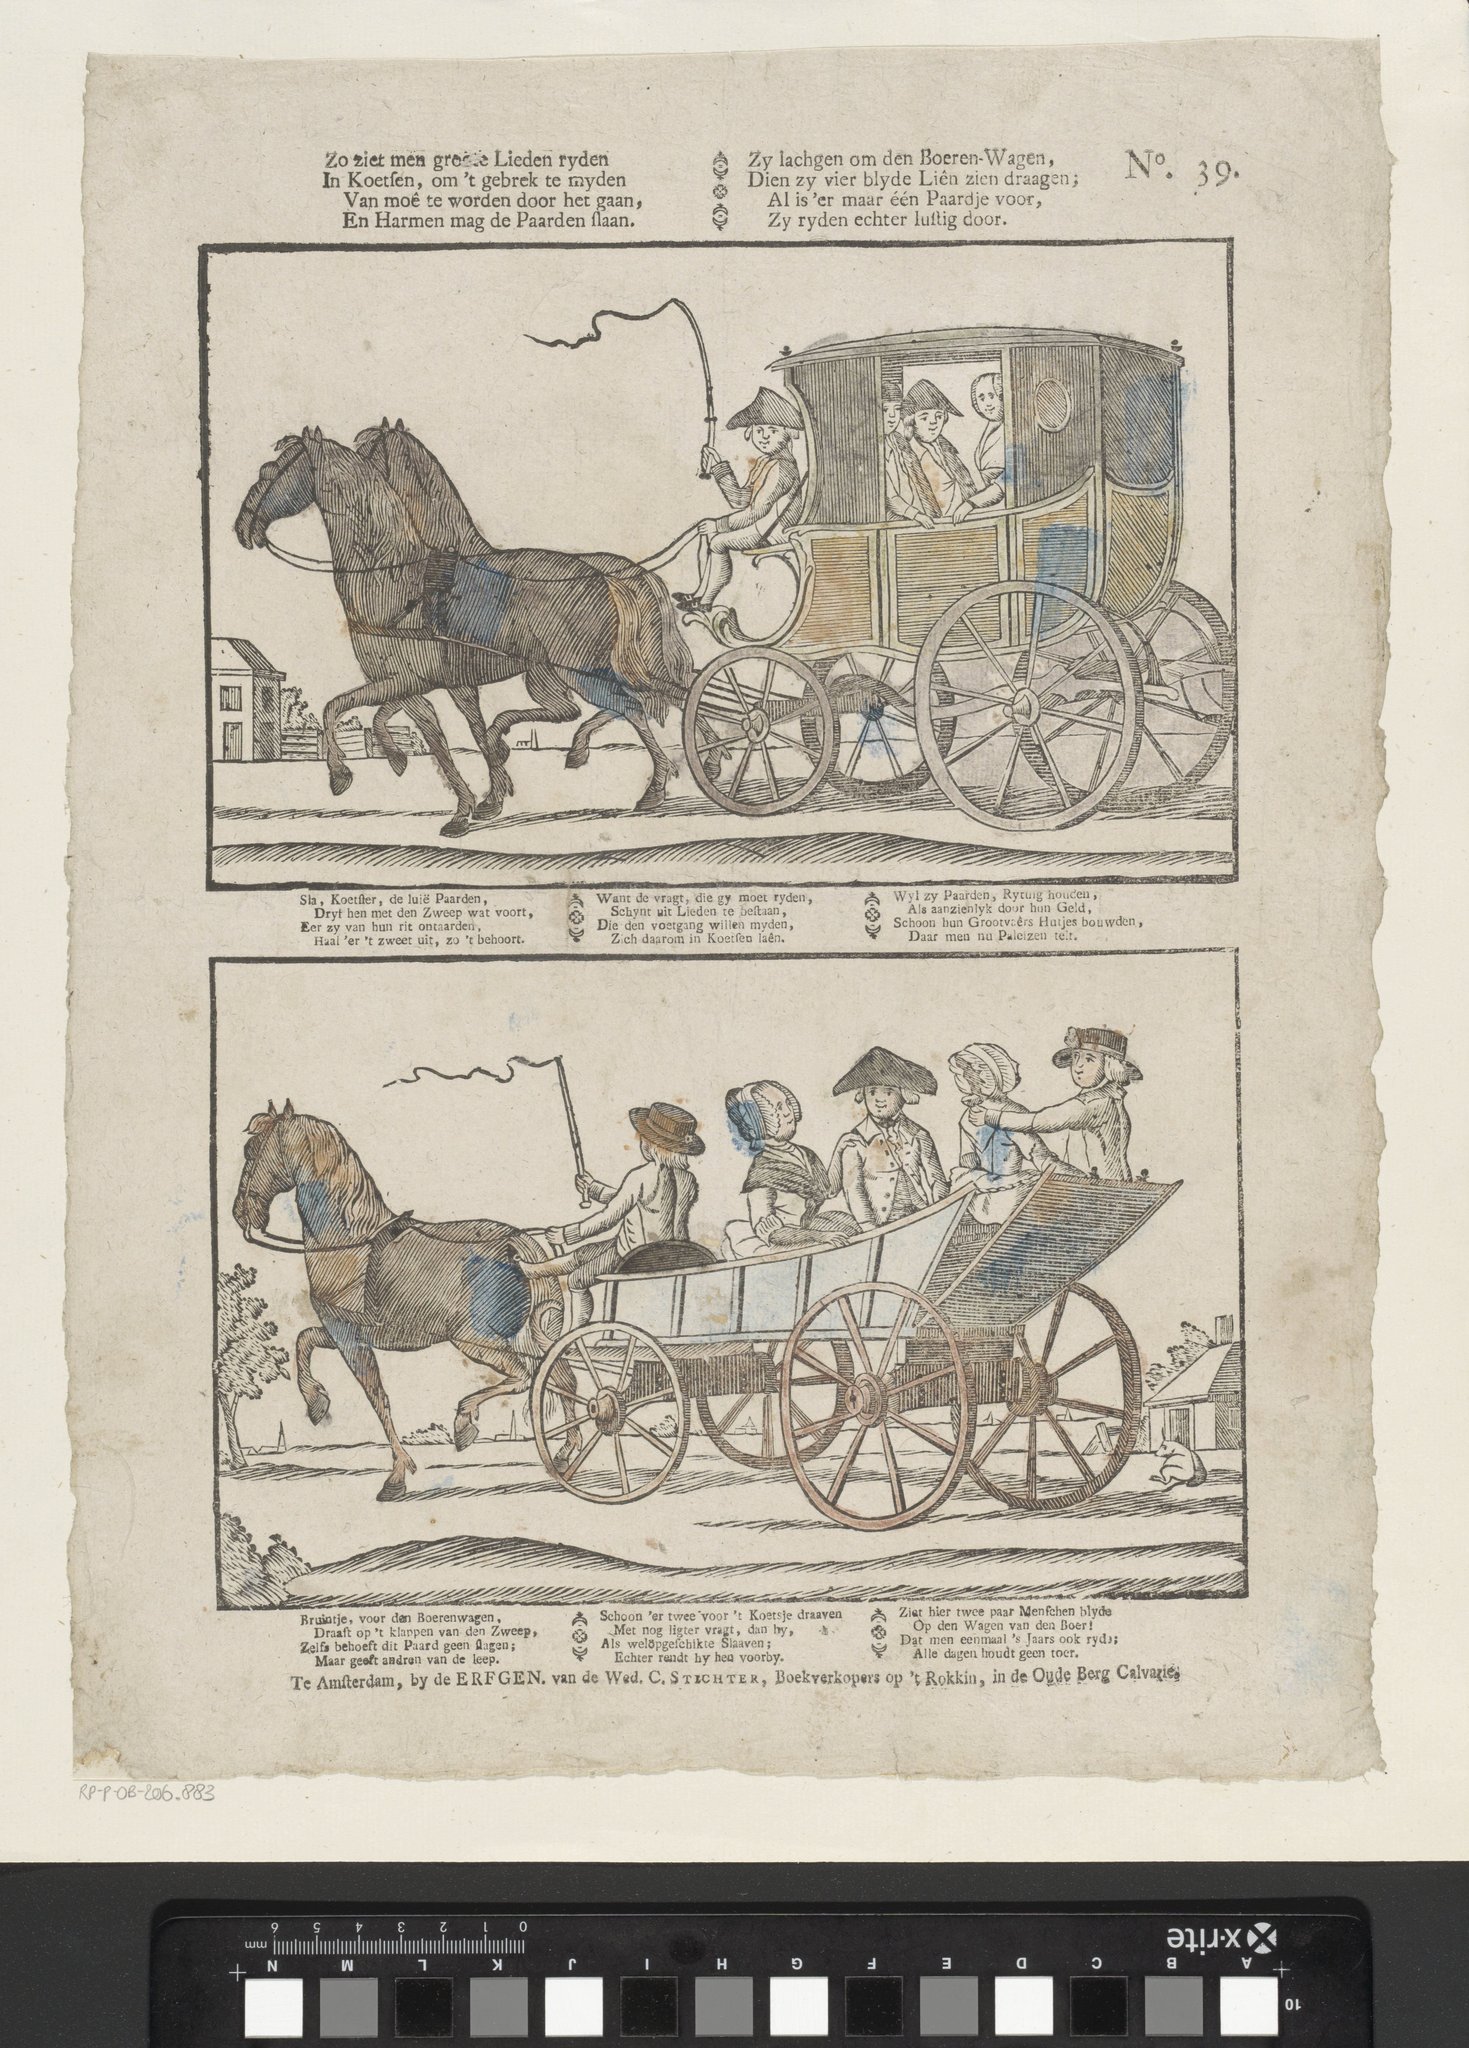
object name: popular print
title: Zo ziet men groote lieden ryden, / In koetsen, op 't gebrek te myden [(...)]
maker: Anonymous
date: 1715-1813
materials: paper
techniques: colour, letterpress printing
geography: netherlands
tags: four-wheeled, animal-drawn vehicle, e.g.: cab, carriage, coach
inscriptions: collector's mark: Lugt 2760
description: Blad met 2 voorstellingen van mensen in rijtuigen. Onder elke afbeelding een twaalfregelig vers in drie kolommen. Genummerd rechtsboven: No. 39.